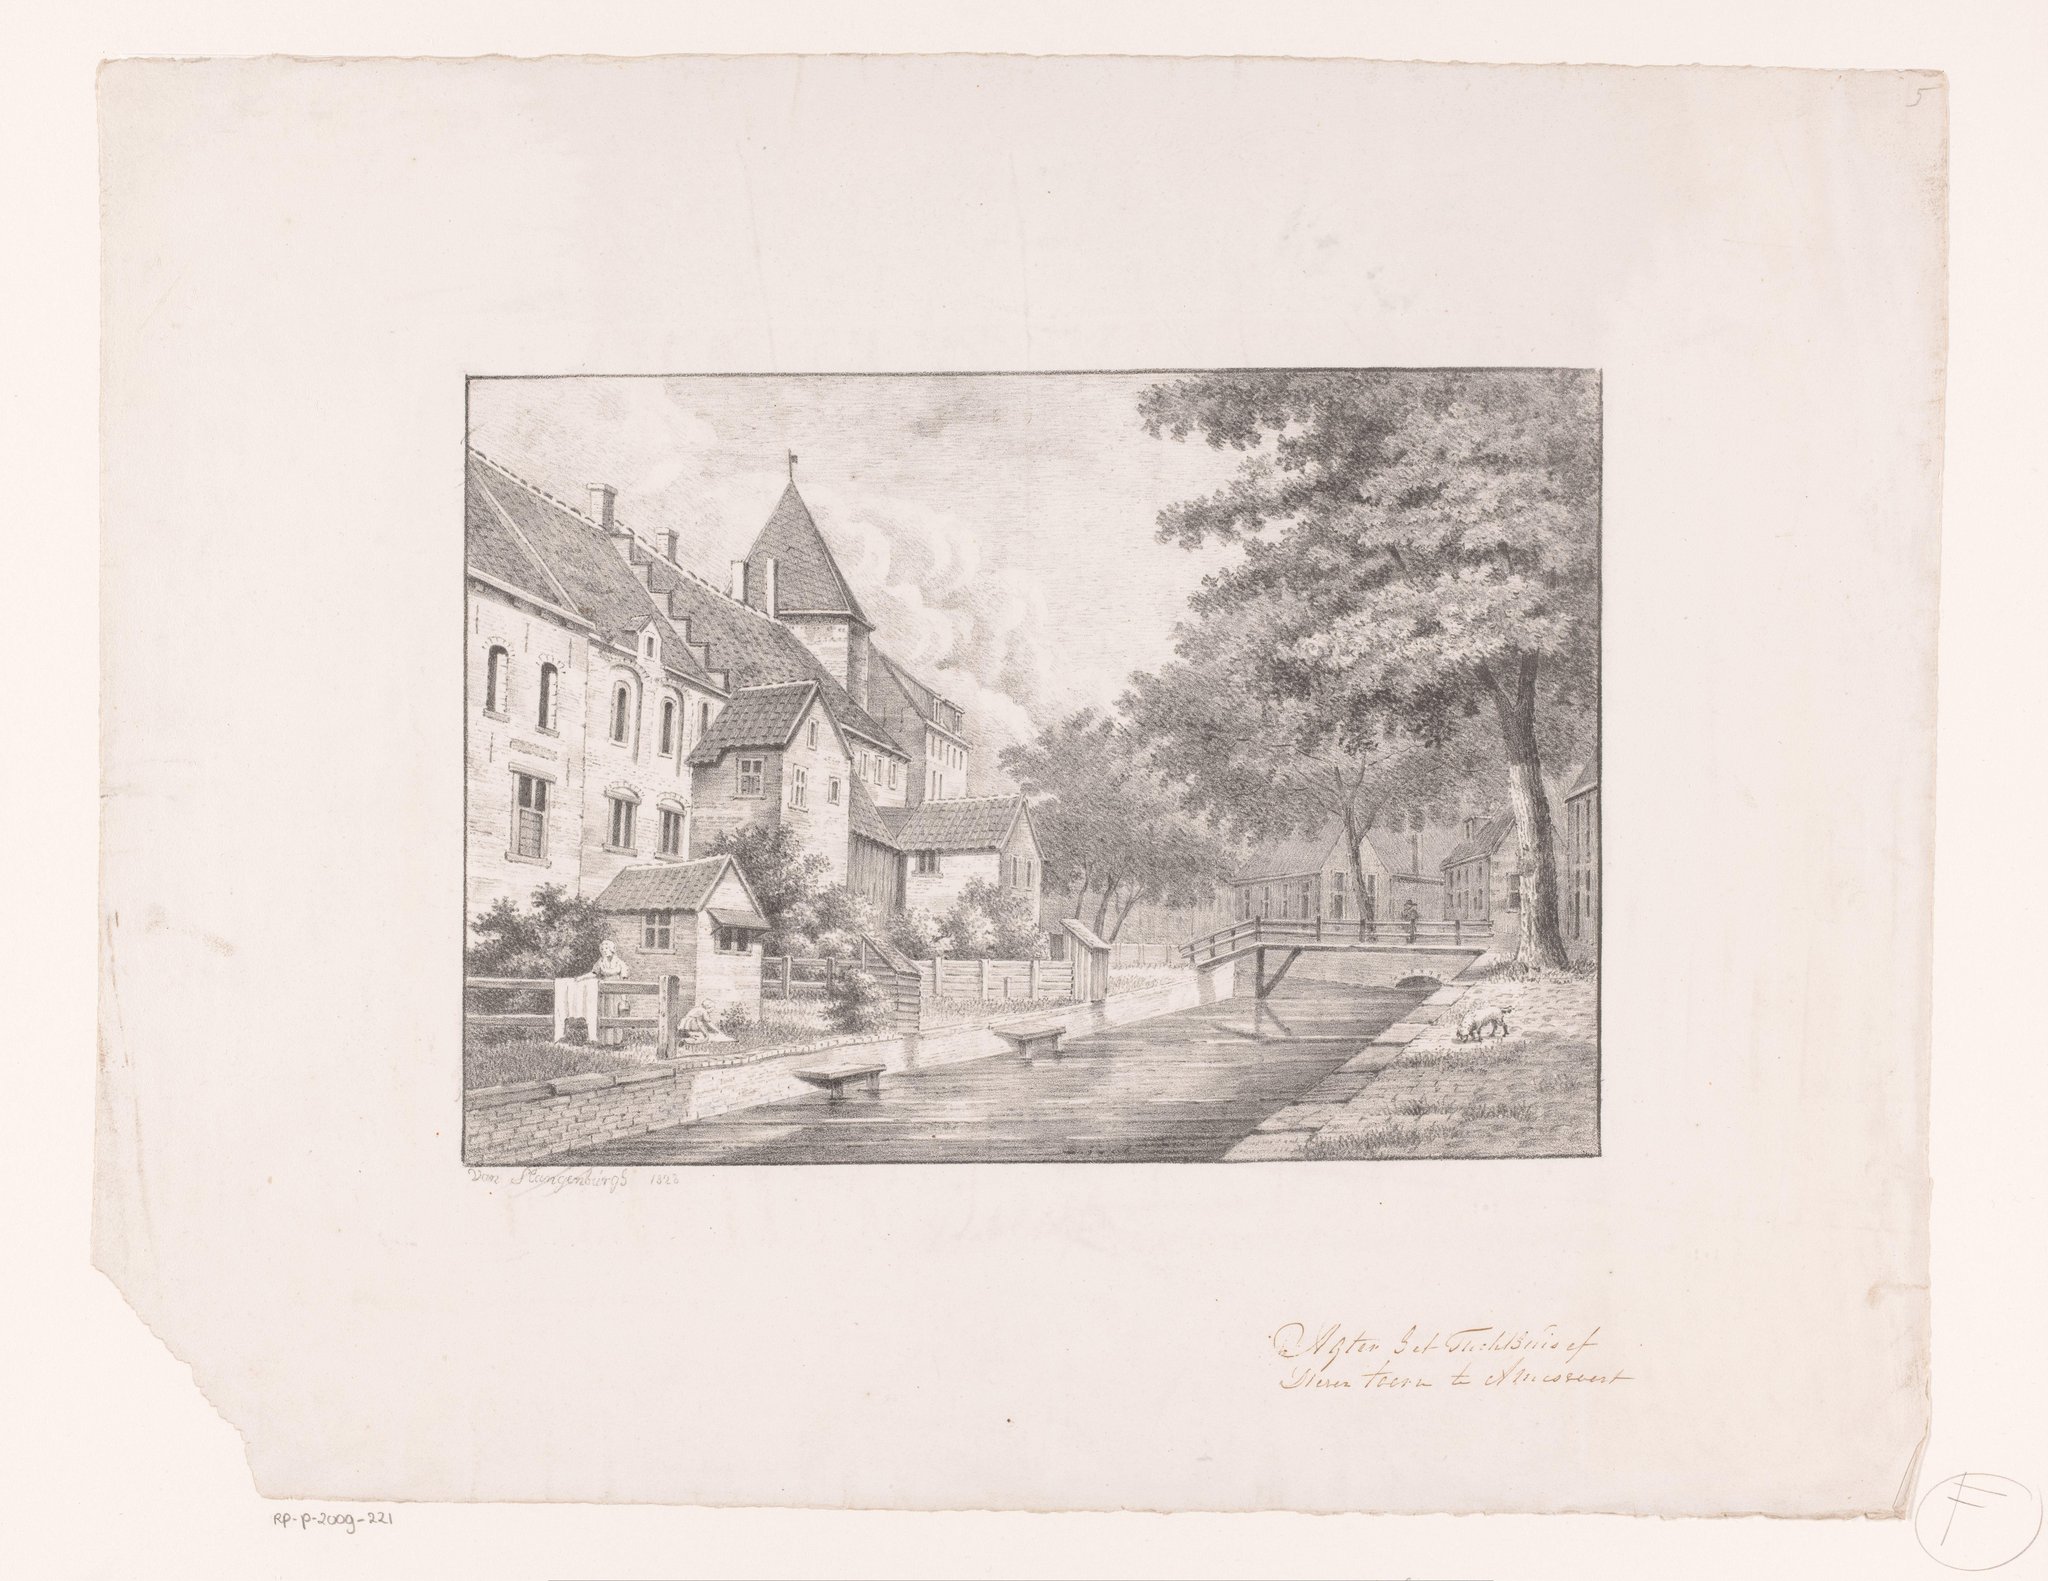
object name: print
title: Achter het tuchthuis te Amersfoort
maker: carel jacob van baar van slangenburg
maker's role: draughtsman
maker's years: 1783-1845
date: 1828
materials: paper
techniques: lithograph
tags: prison, jail, canals, waters (in city)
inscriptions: inscription: ‘Agter het Tuchthuis ef / (...) te Amersfoort’, collector's mark: Lugt 2760, collector's mark: Lugt 2228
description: Gezicht op een gracht achter het tuchthuis te Amersfoort.